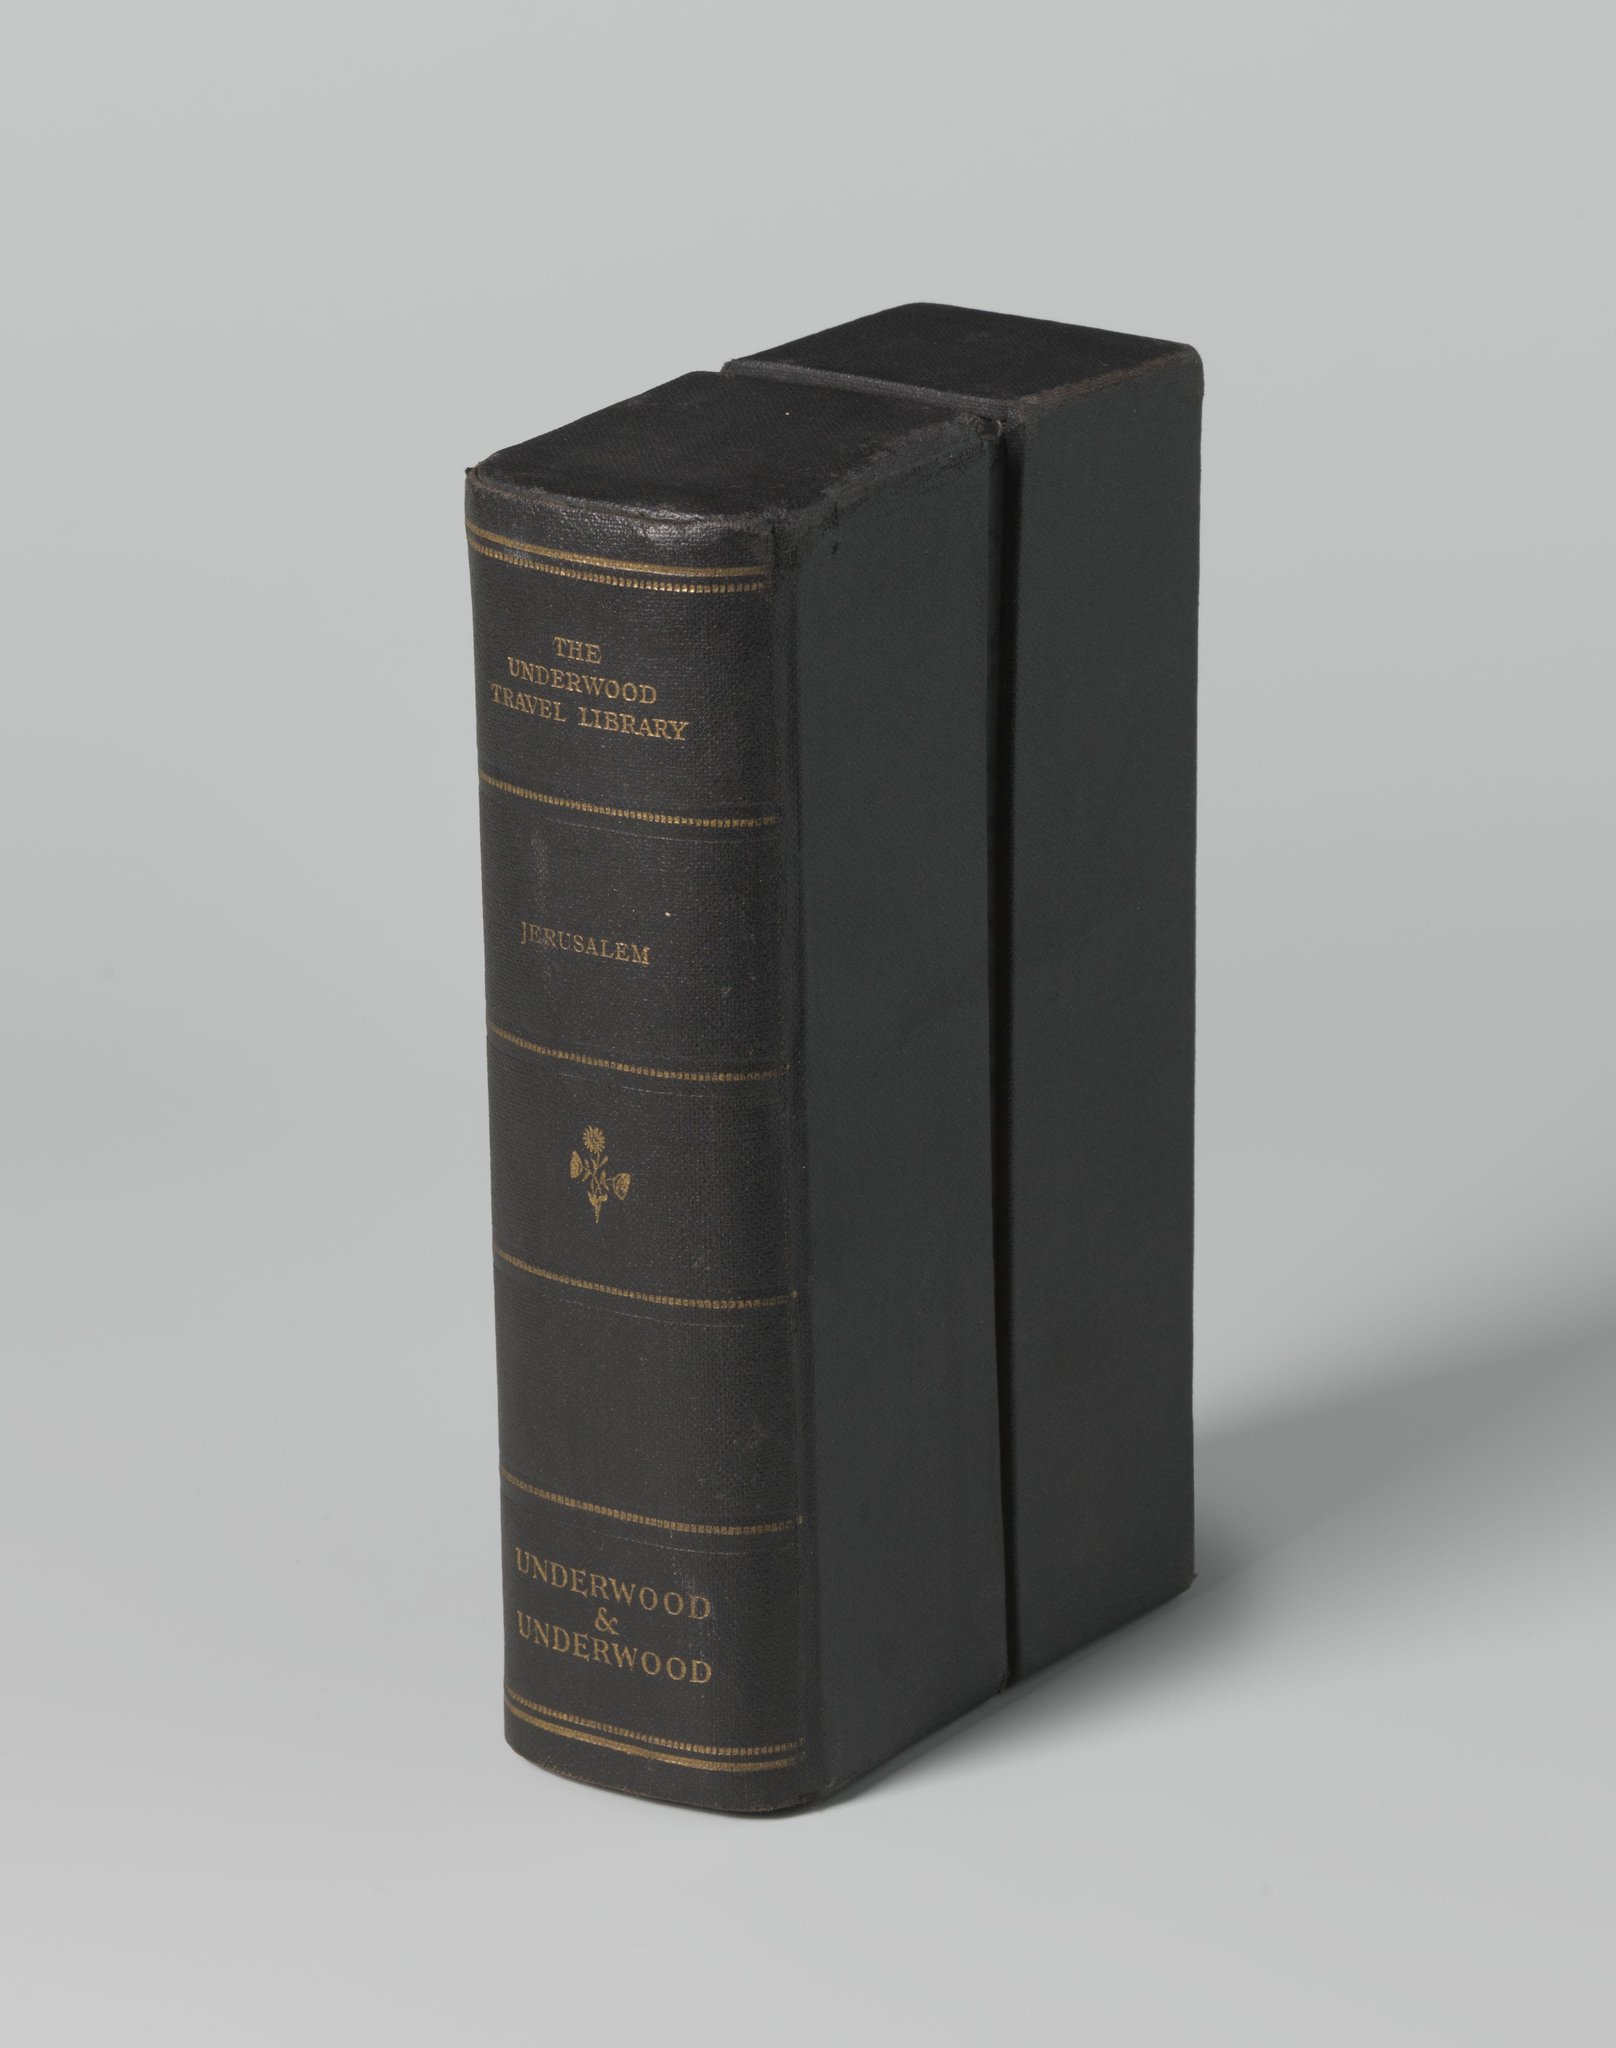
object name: box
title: Doos voor stereofoto's in de vorm van een boek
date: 1890-1910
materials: cardboard, leather, paper, textile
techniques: moire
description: Doos in de vorm van een boekband, voor het opbergen van stereofoto's (leeg).